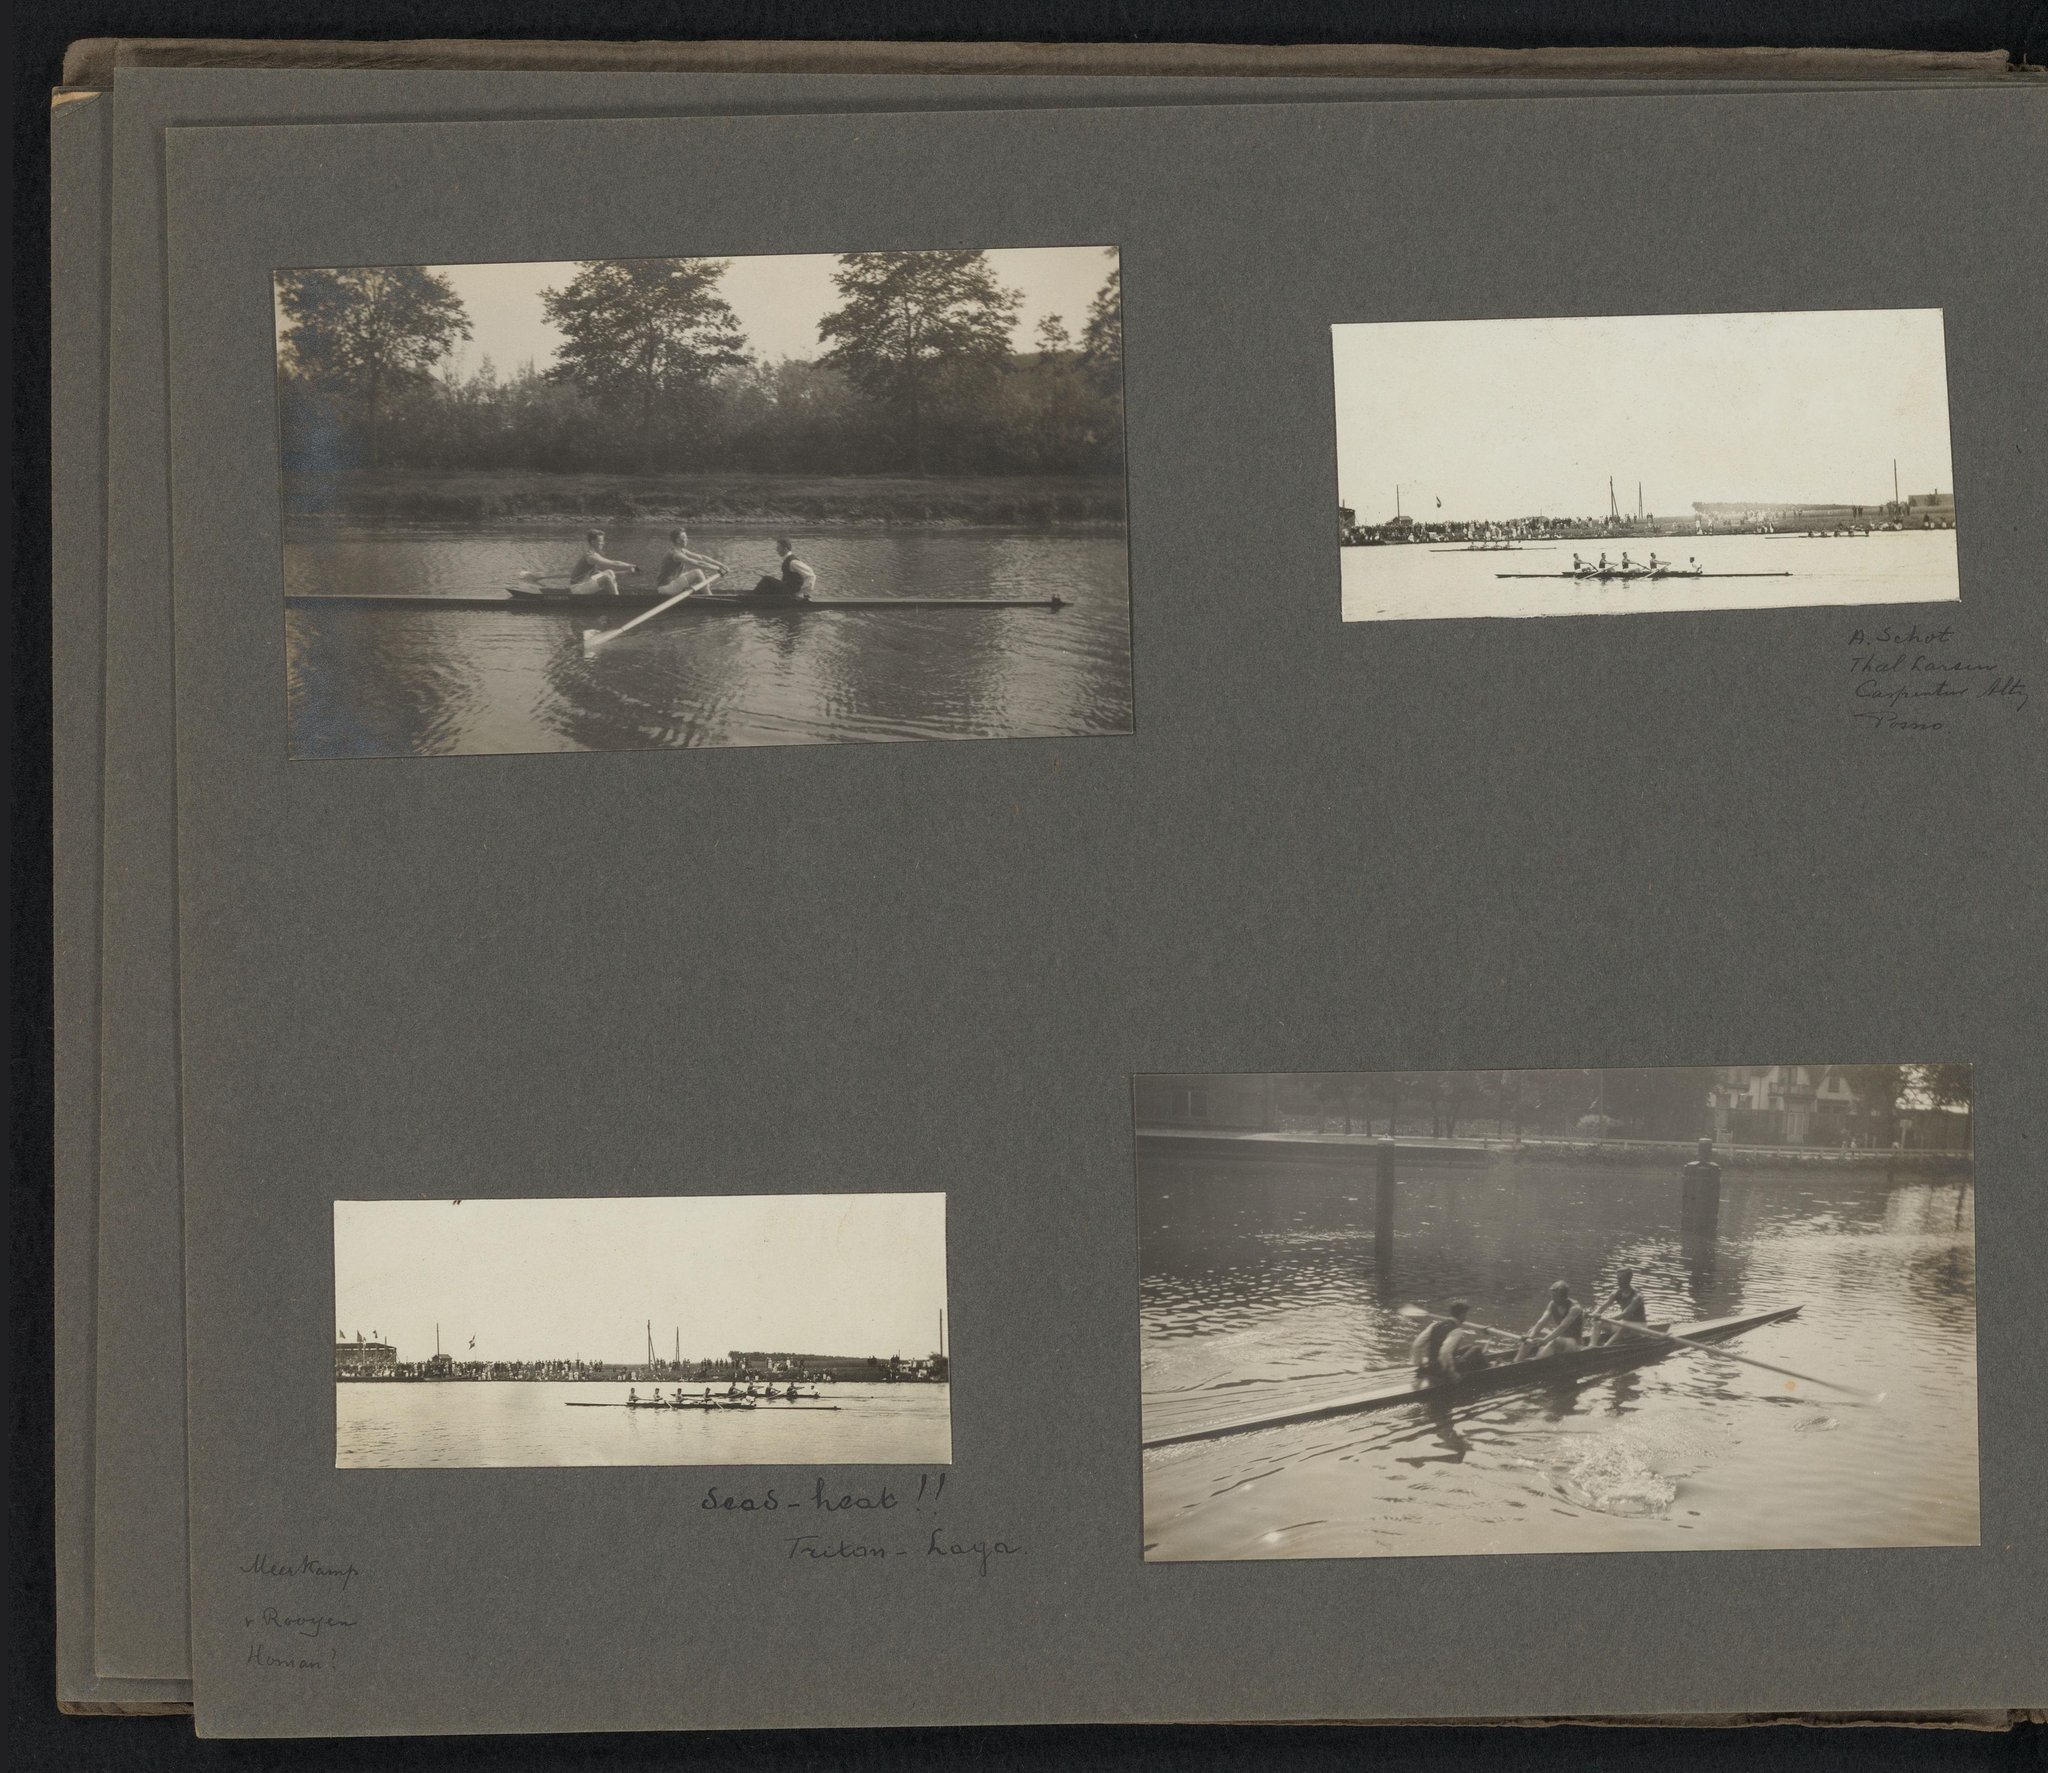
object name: album leaf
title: Vier foto's van verschillende roeiploegen in actie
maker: Anonymous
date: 1916-1917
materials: paper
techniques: gelatin silver print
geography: netherlands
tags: rowing facing backward, pulling, rowing, canoeing, etc. (sport)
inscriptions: caption: ‘A. Schot/ Thoel Larsen/ Carpenter Alty/ Posno/ Seas-heat!!/ Triton-Laga/ Meerkamp/ v Rooyen/ Hornan?’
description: Deze foto's maken deel uit van een album.